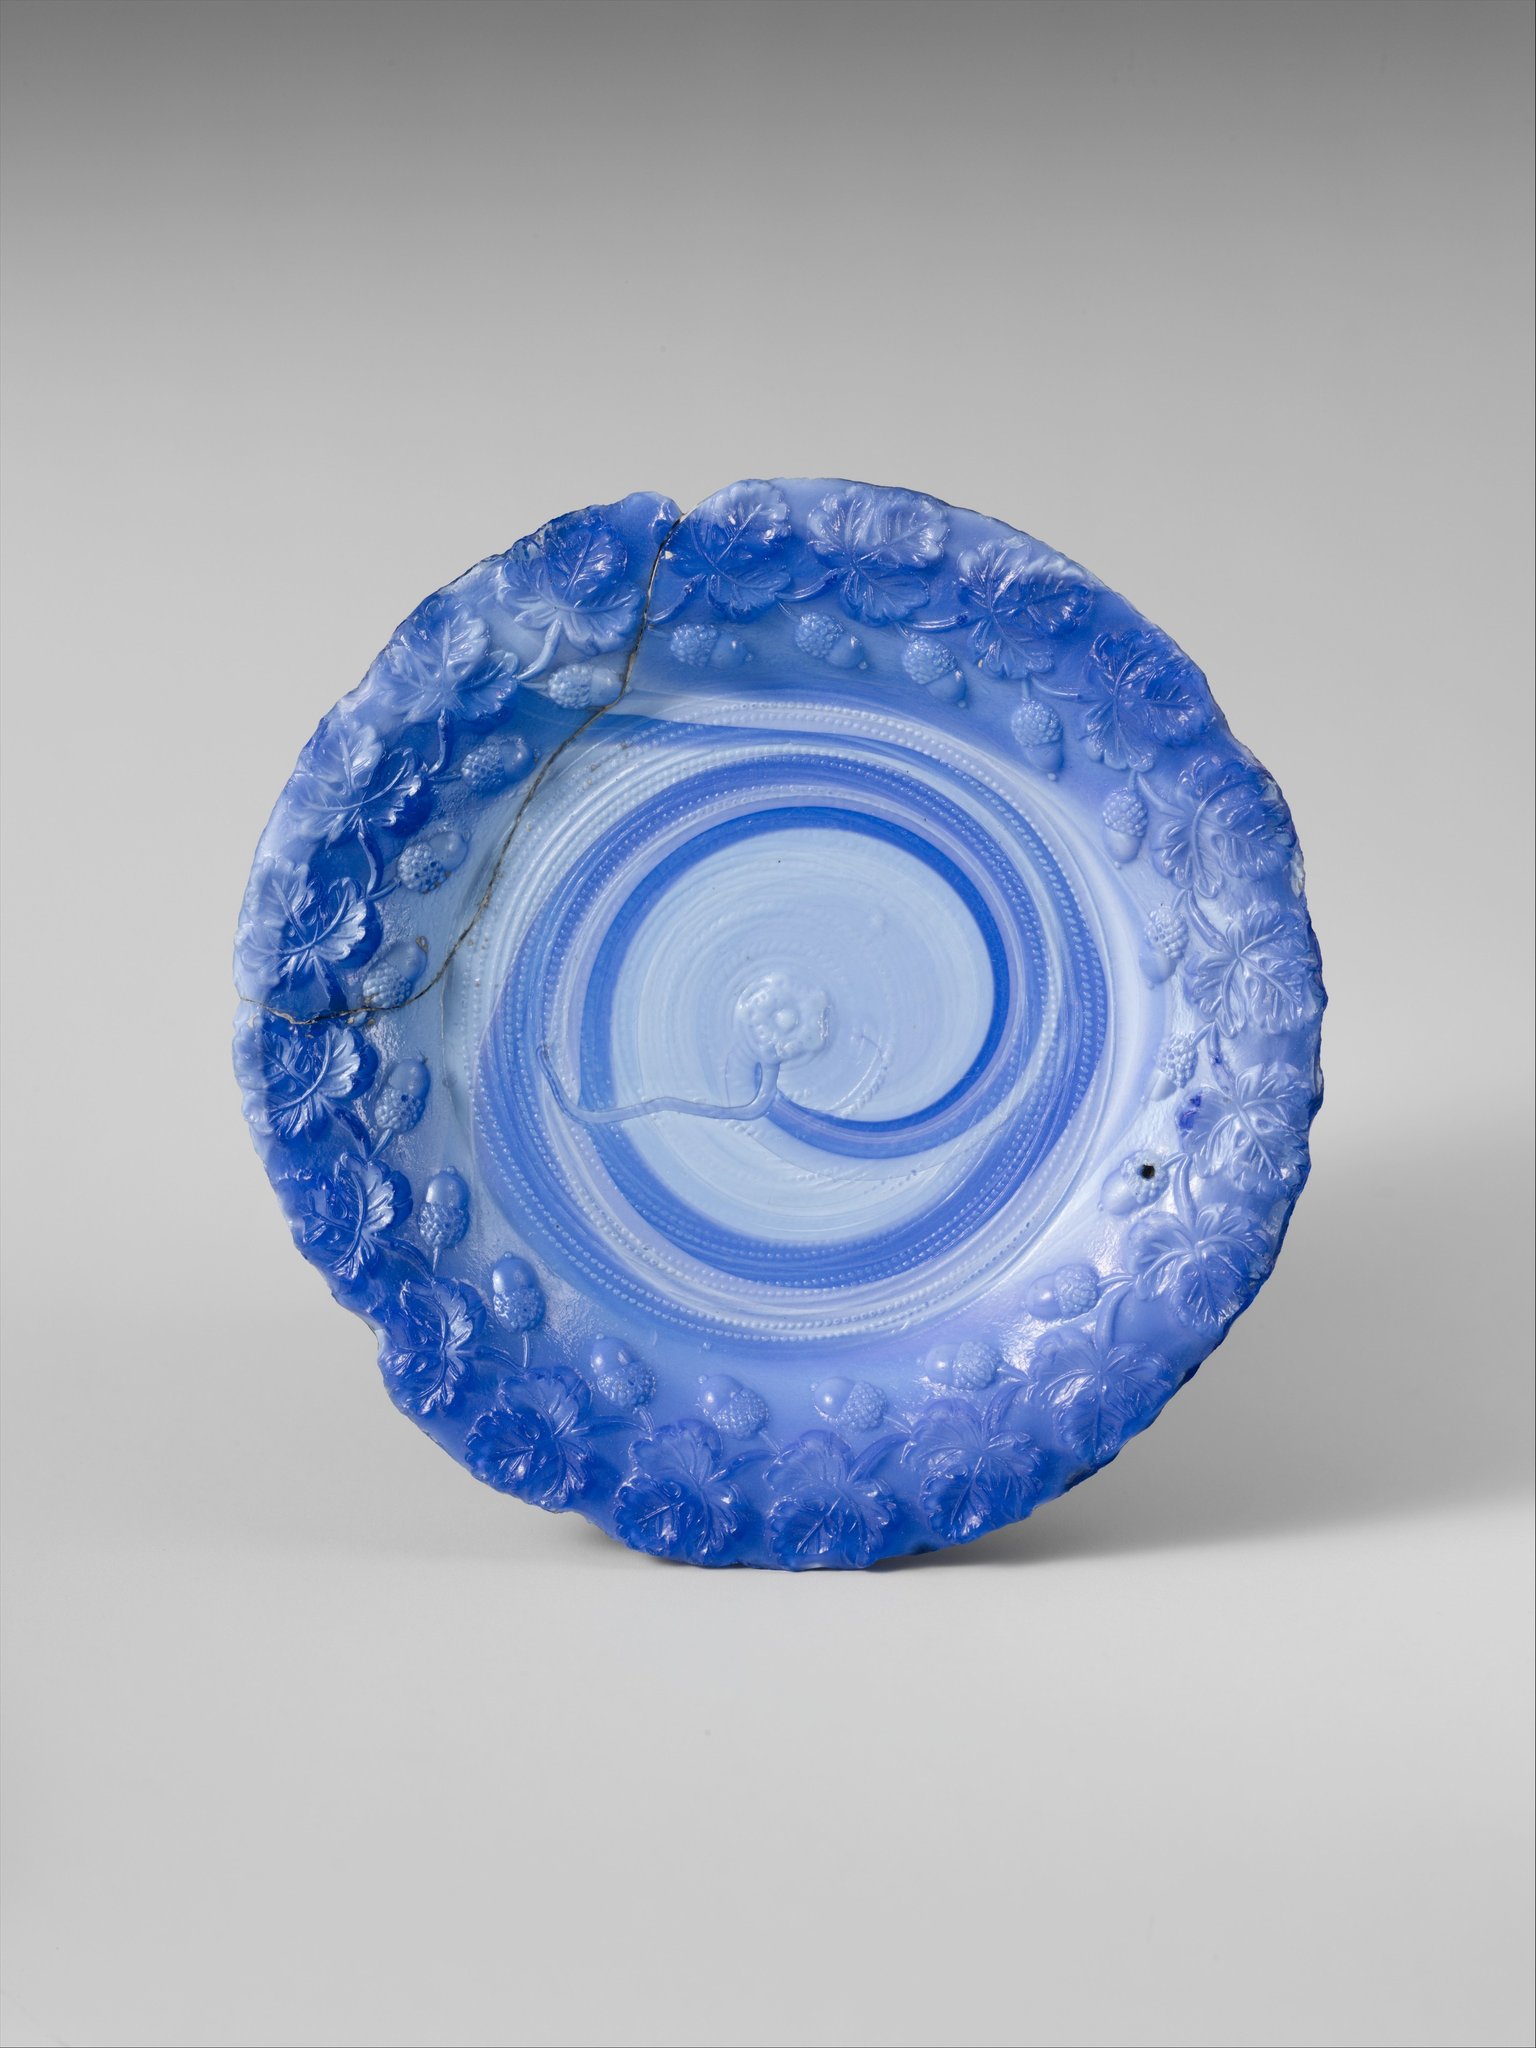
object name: cup plate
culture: american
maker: boston & sandwich glass company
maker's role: maker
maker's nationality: american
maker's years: 1825-1888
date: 1801-1900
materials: glass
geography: united states